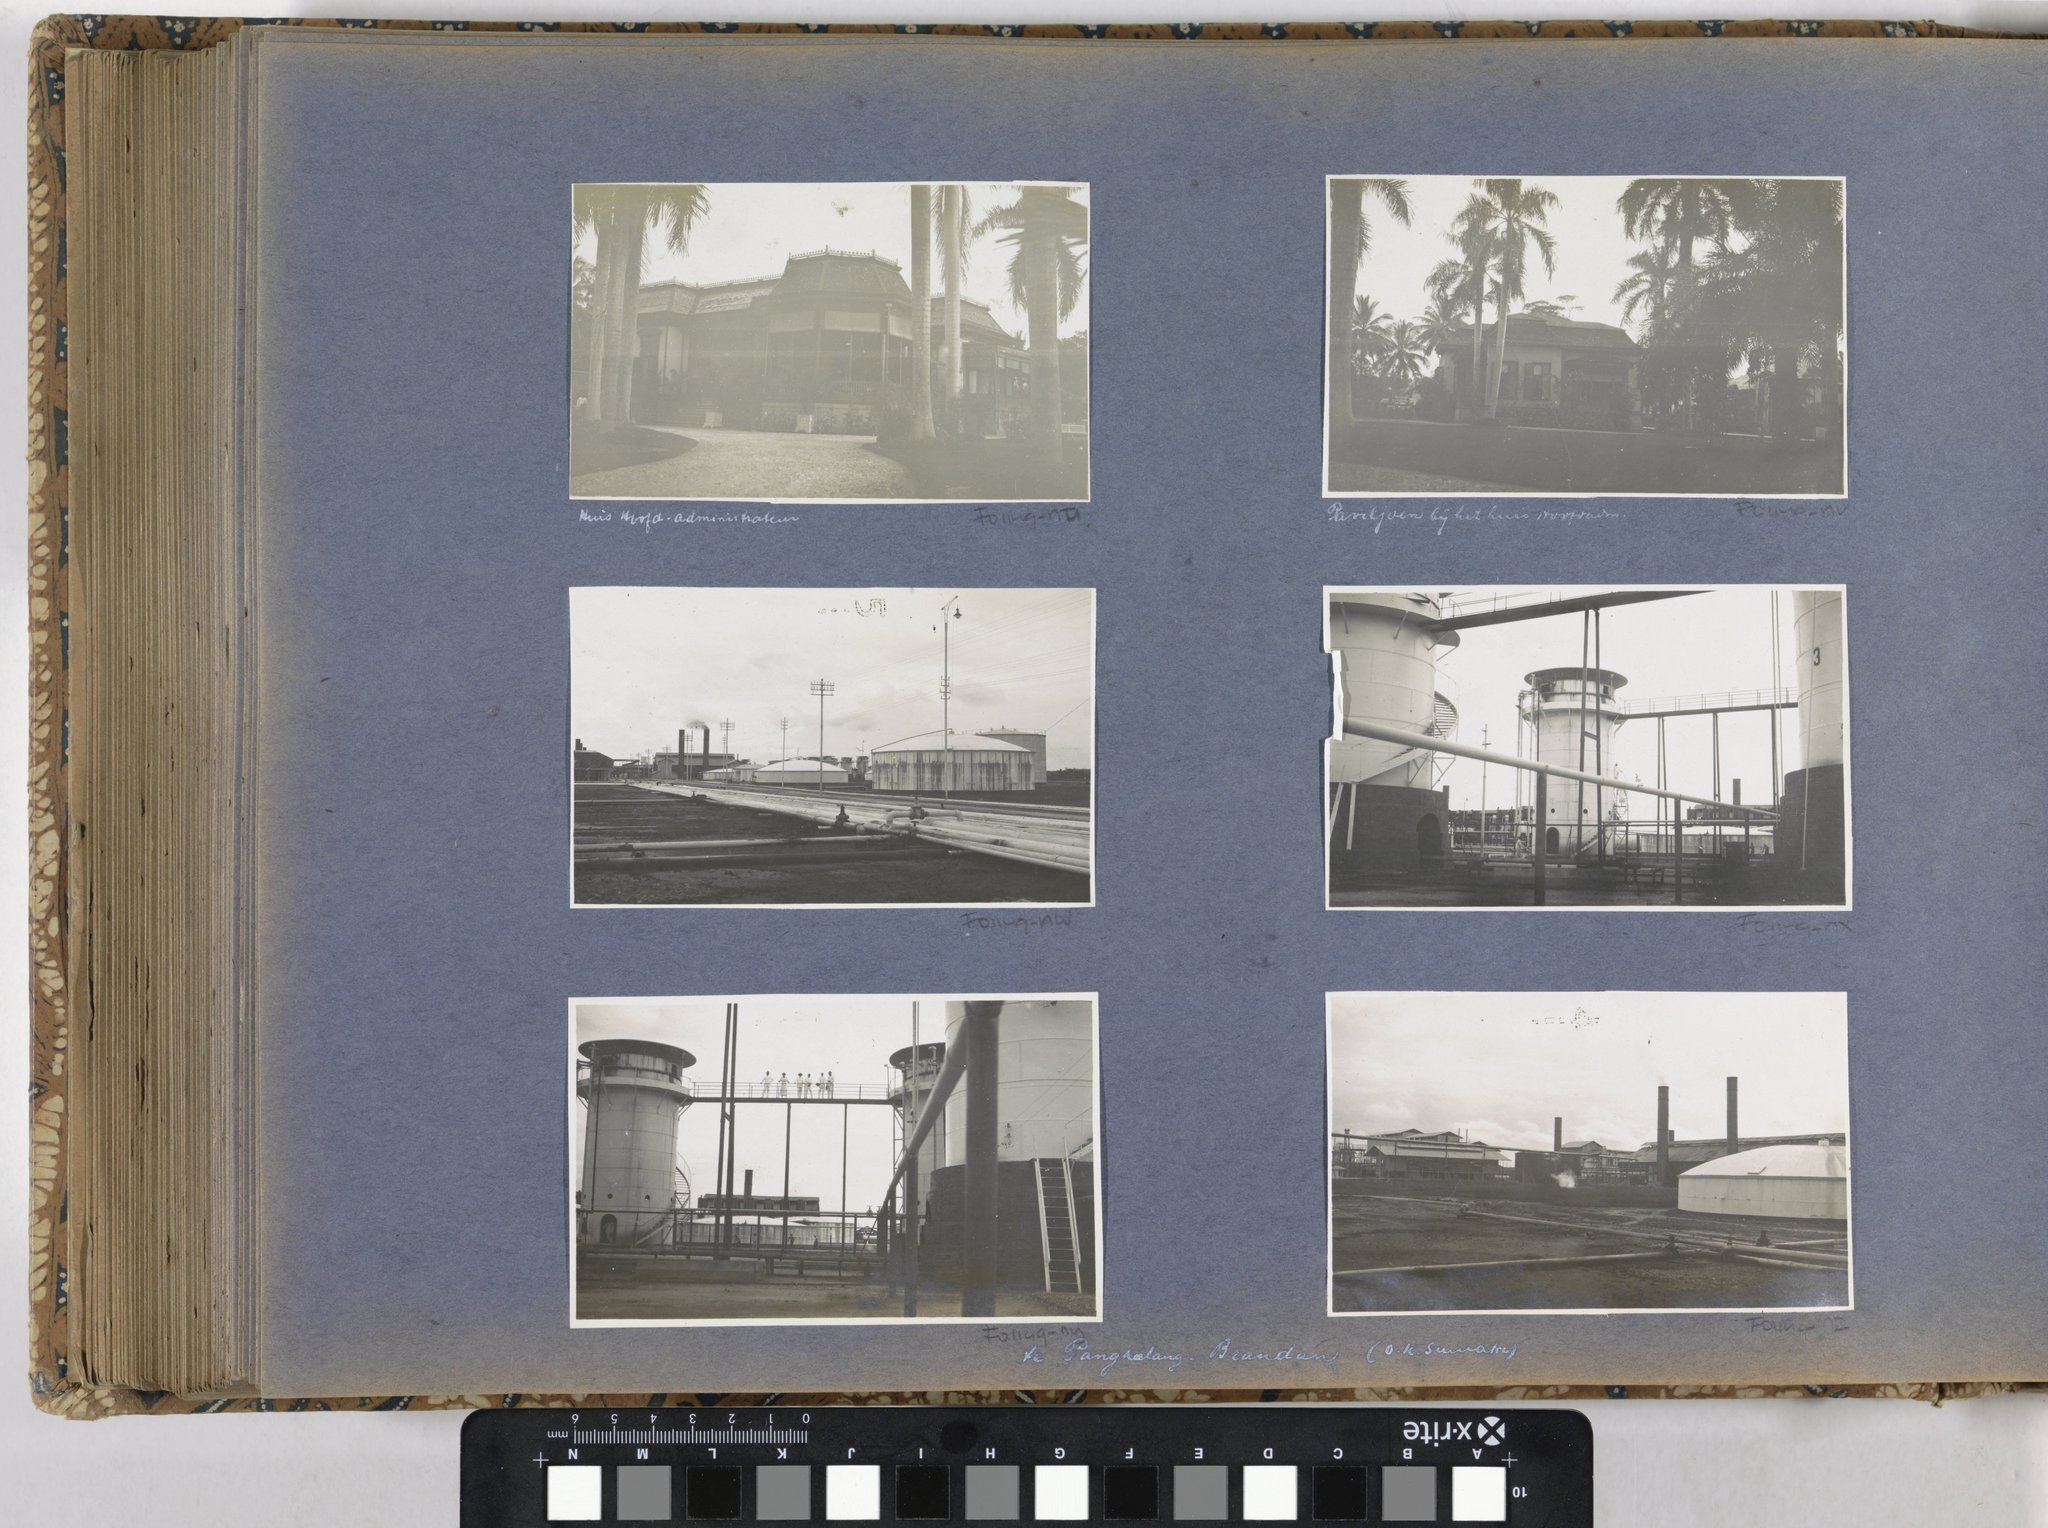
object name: photograph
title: Fabriekscomplex voor oliewinning te Pangkalan-Brandan op Sumatra, op een loopbrug zes personen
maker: Anonymous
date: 1900-1920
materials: paper, photographic support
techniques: gelatin silver print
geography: sumatra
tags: oil tanks, oil; oil refinery, sumatra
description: Onderdeel van reisalbum met foto's van bedrijvigheid en bezienswaardigheden op Sumatra en Java en van de reis naar en van Nederlands-Indië.